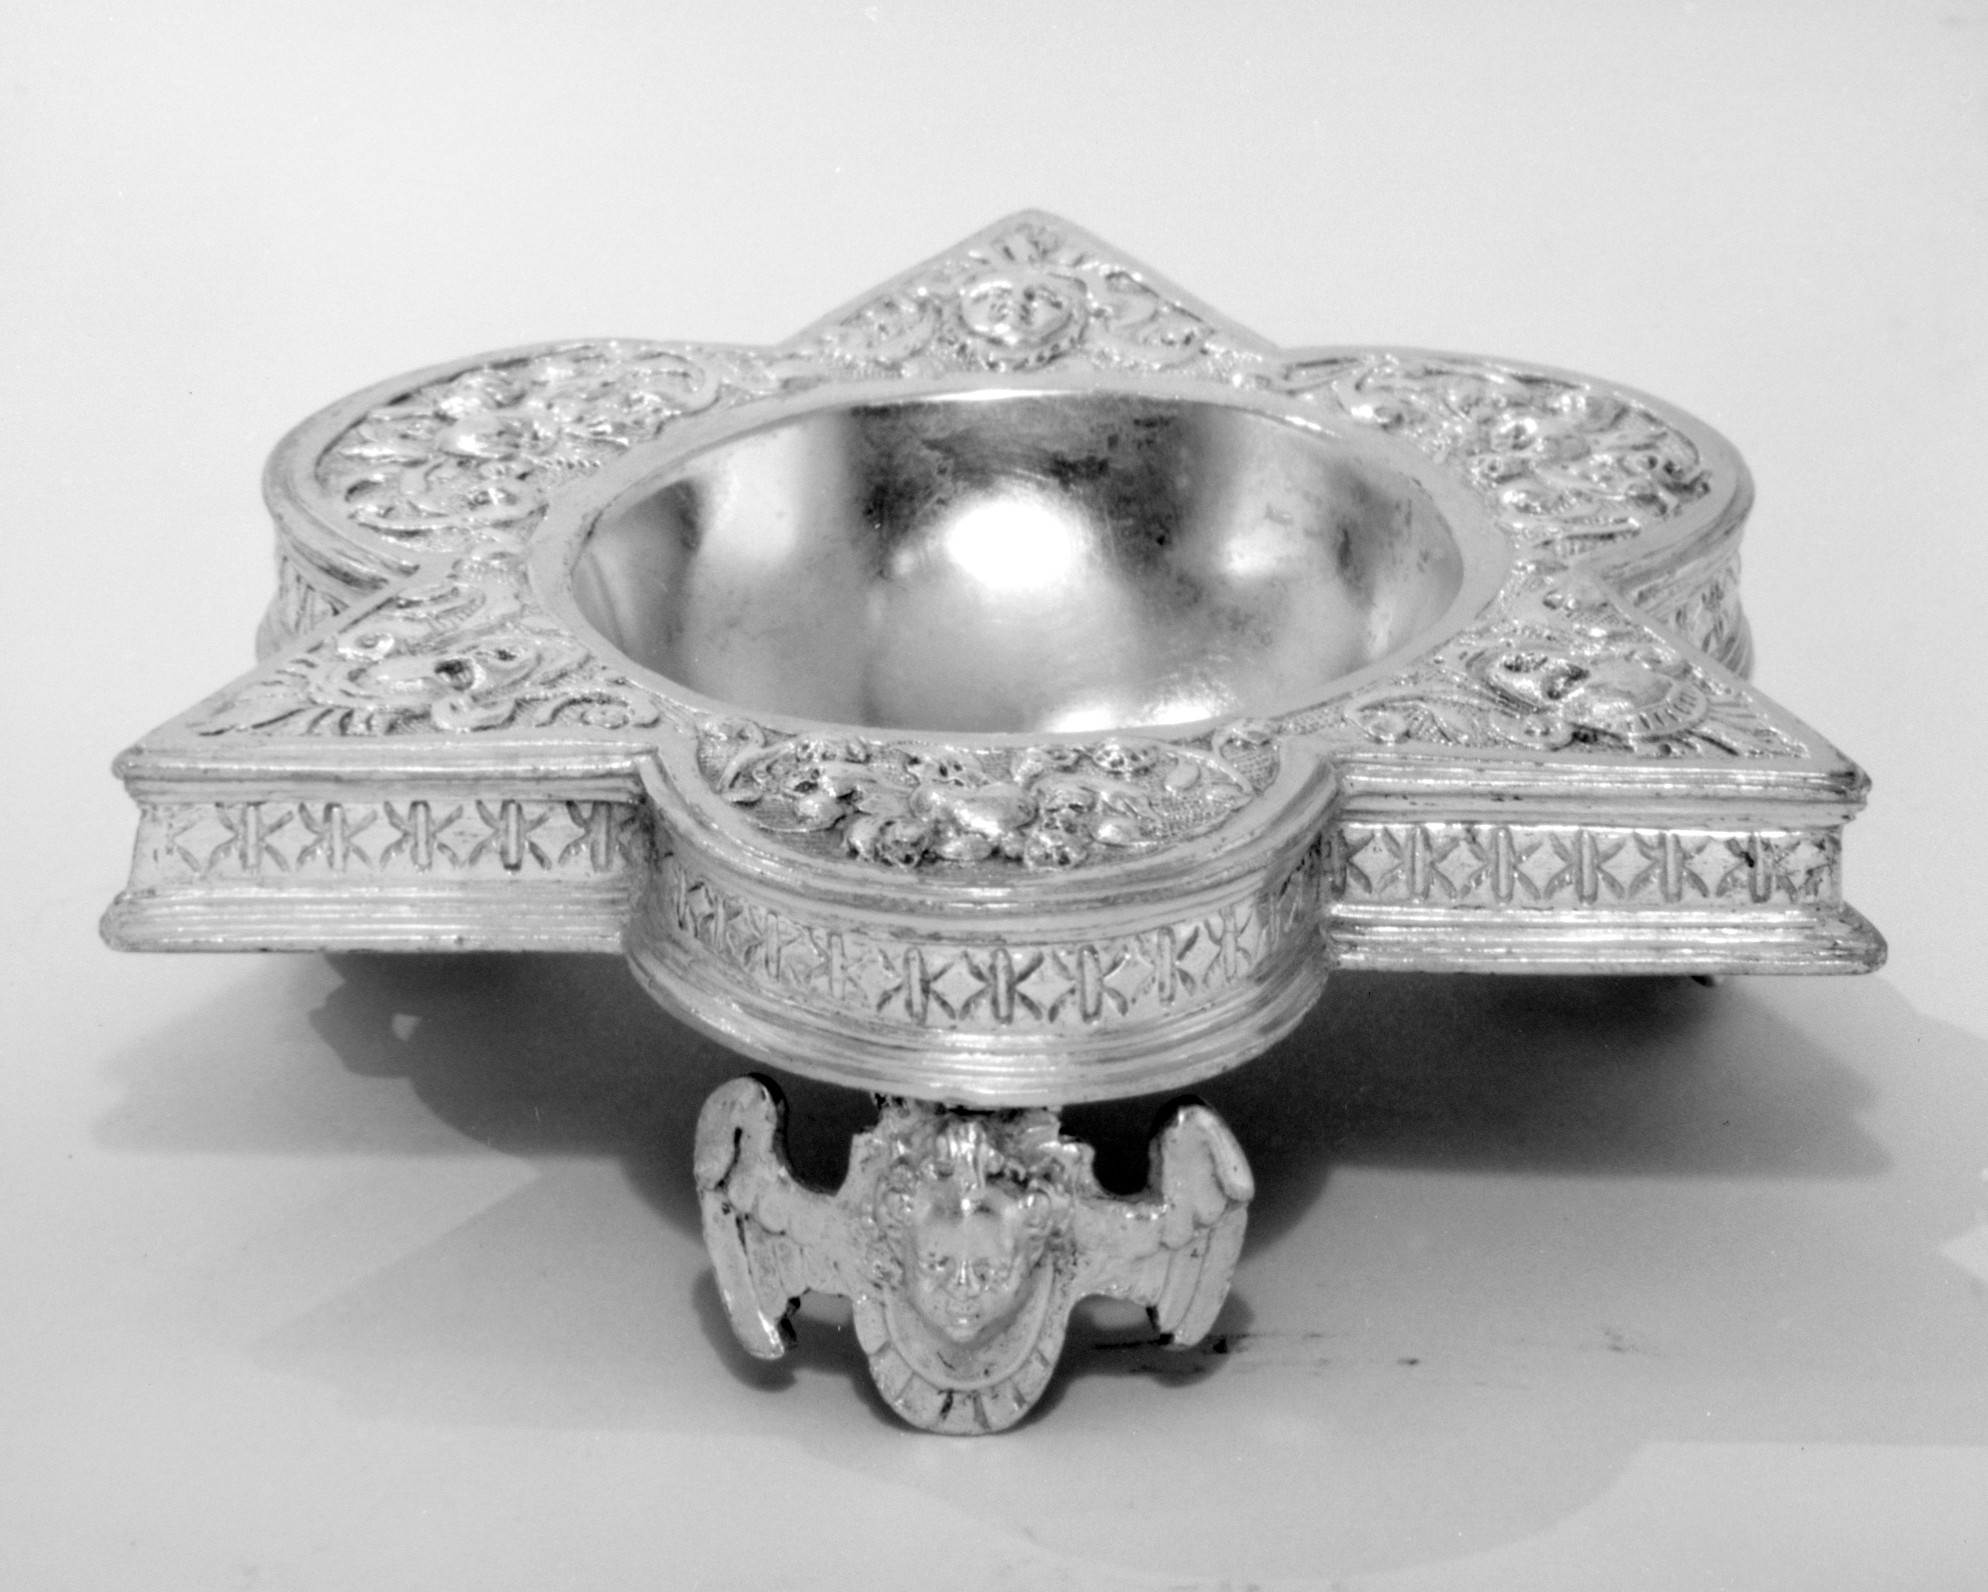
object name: saltcellar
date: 1801-1900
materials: metal, silver